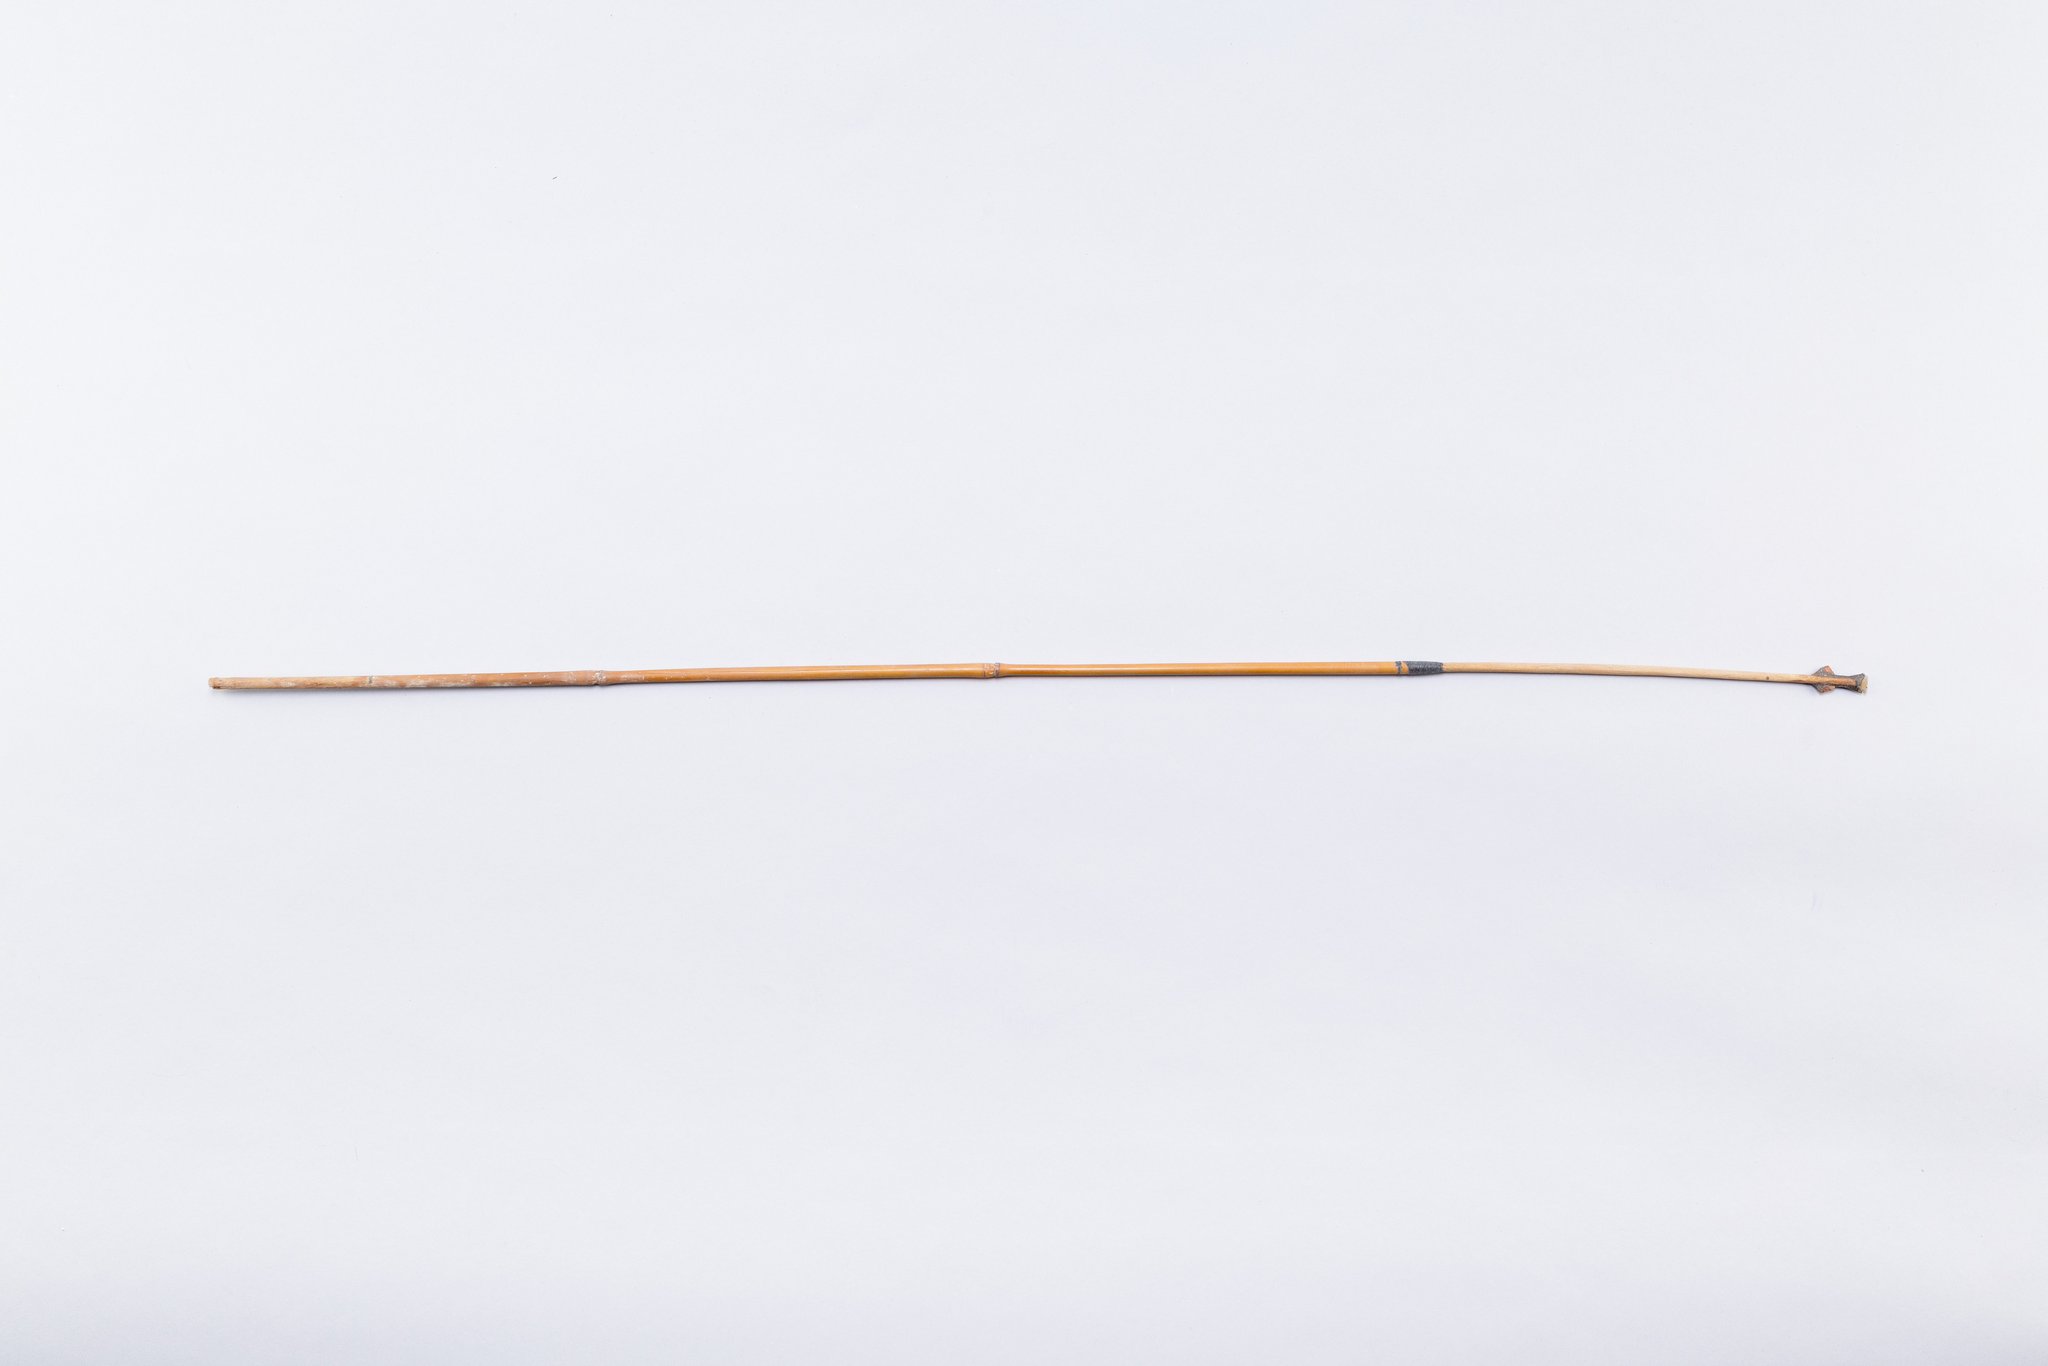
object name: arrow, arrowhead, adhesive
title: Arrow with composite stone tip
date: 1479-1458 BCE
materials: quartz, wood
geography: egypt